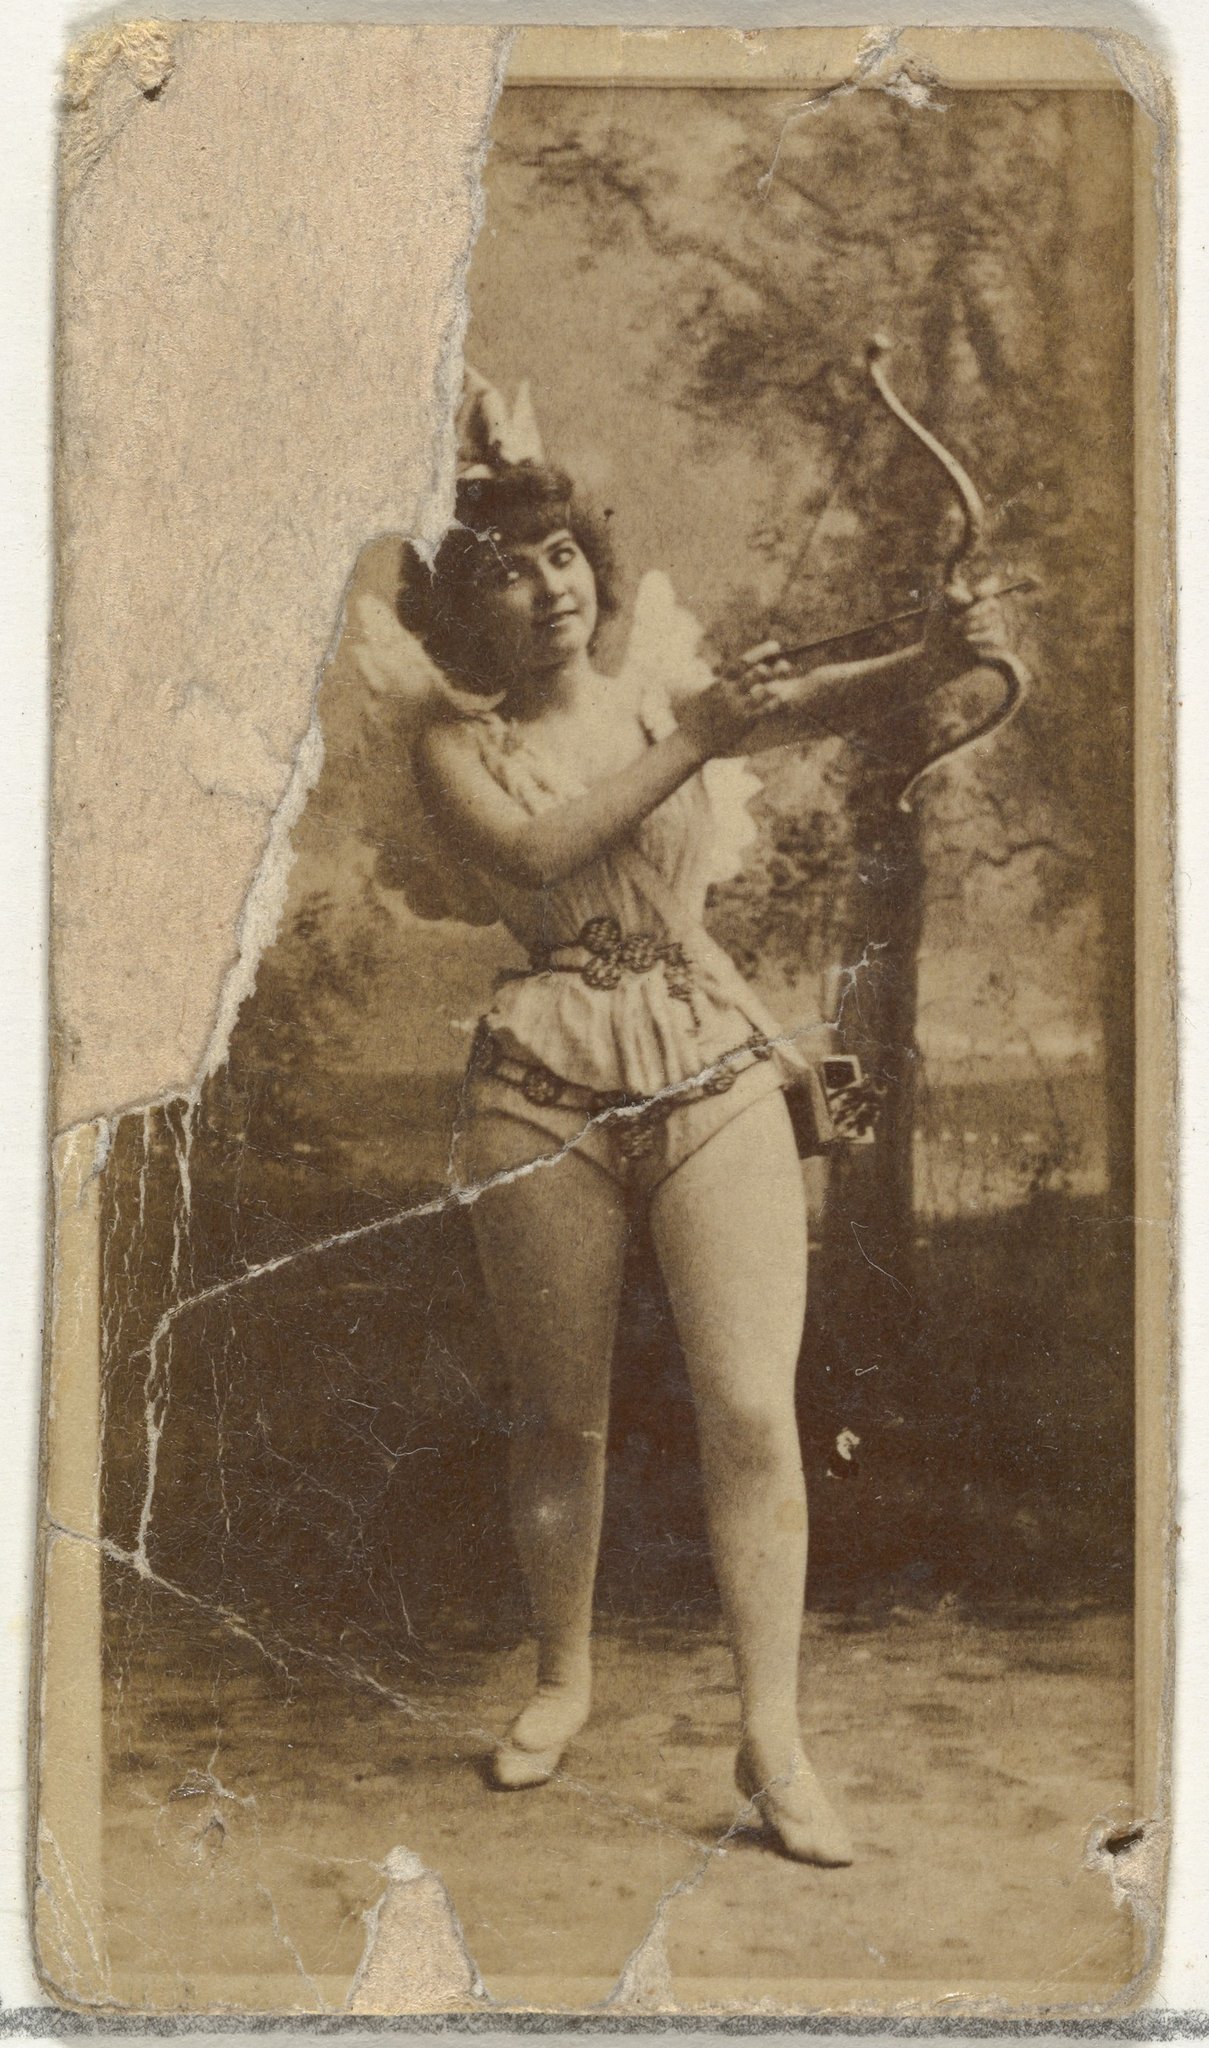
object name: photograph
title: [Actress dressed as cupid], from the Actors and Actresses series (N145-8) issued by Duke Sons & Co. to promote Duke Cigarettes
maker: w. duke, sons & co.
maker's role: publisher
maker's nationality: american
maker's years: 1870-1920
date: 1891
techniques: albumen silver print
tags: bow and arrow,portraits,women,actresses